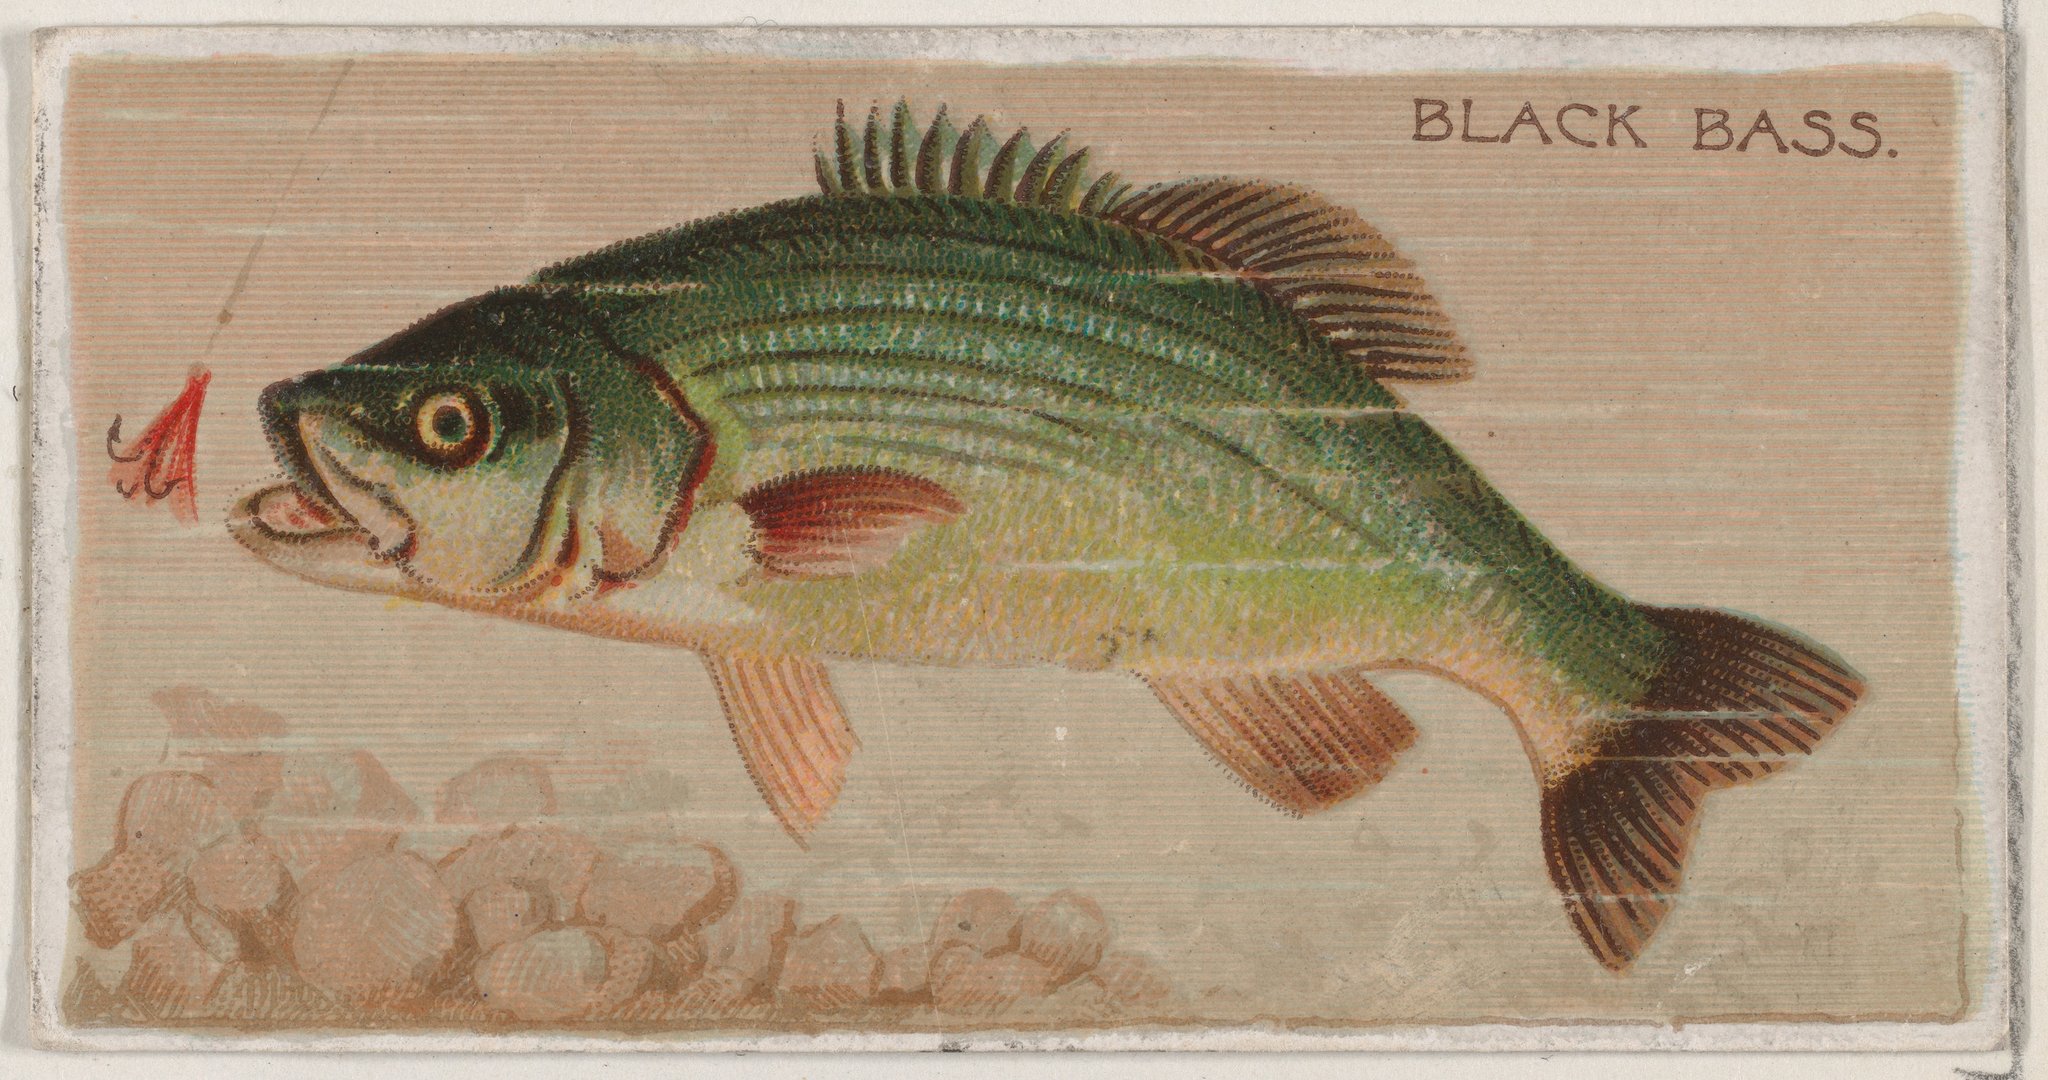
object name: print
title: Black Bass, from the series Fishers and Fish (N74) for Duke brand cigarettes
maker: knapp & company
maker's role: lithographer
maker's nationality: american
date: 1888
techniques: color lithograph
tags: fish